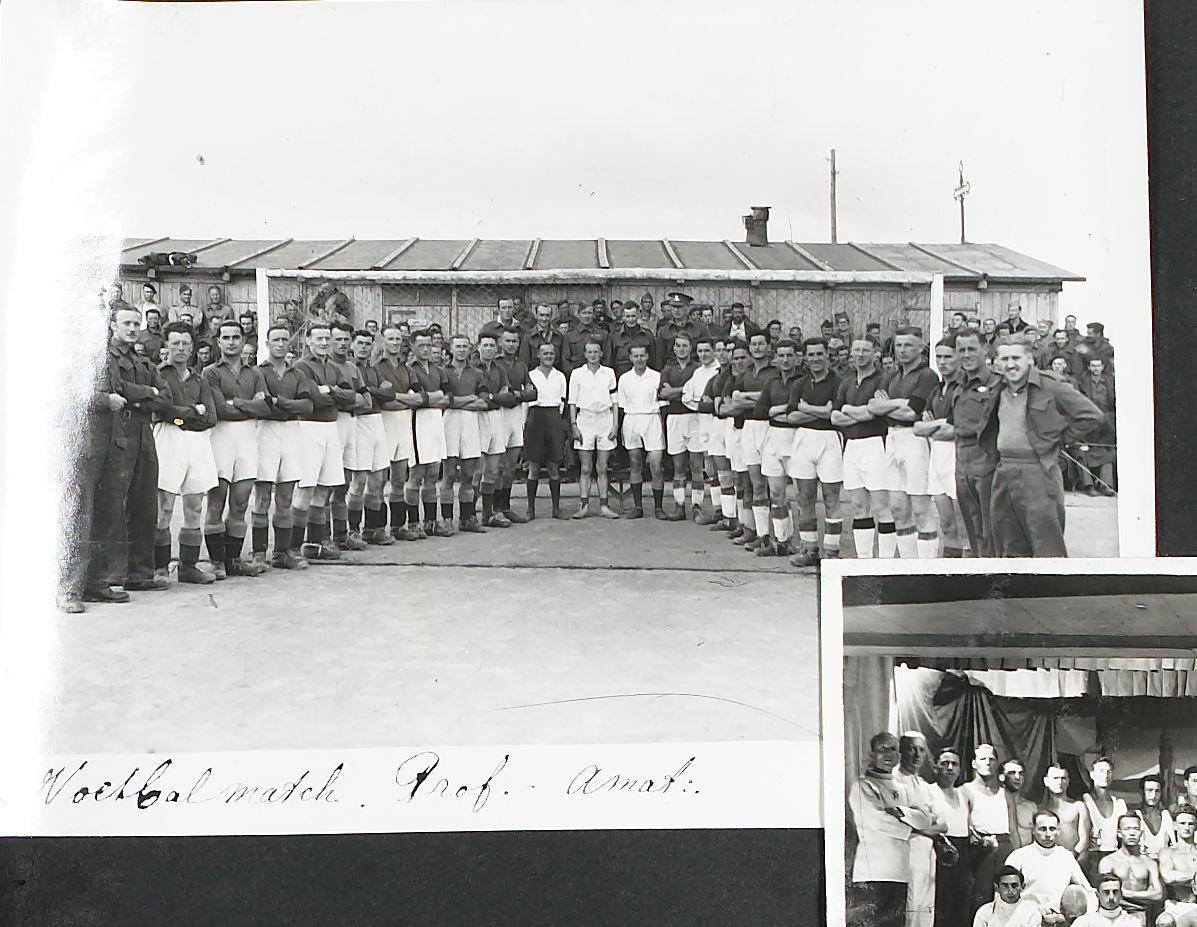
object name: album leaf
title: Holl. Vrid. Smiling. Eng. Jones / Internat: Boxers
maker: dick w.b. van maarseveen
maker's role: fotograaf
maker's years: 1905-1990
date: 1943-1945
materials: cardboard, photographic support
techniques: gelatin silver print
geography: muhlberg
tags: dick w.b. van maarseveen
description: Albumblad met twee foto's: een bokswedstrijd tussen een Nederlander genaamd Vrid. Smiling en een Engelsman Jones en een groepsfoto van boksers van verschillende nationaliteiten, poserend staande in de rij. Onderdeel van een fotoalbum met foto's door Dick van Maarseveen van het krijgsgevangenenkamp Stalag IV B in Mühlberg in de periode 1943-1945.